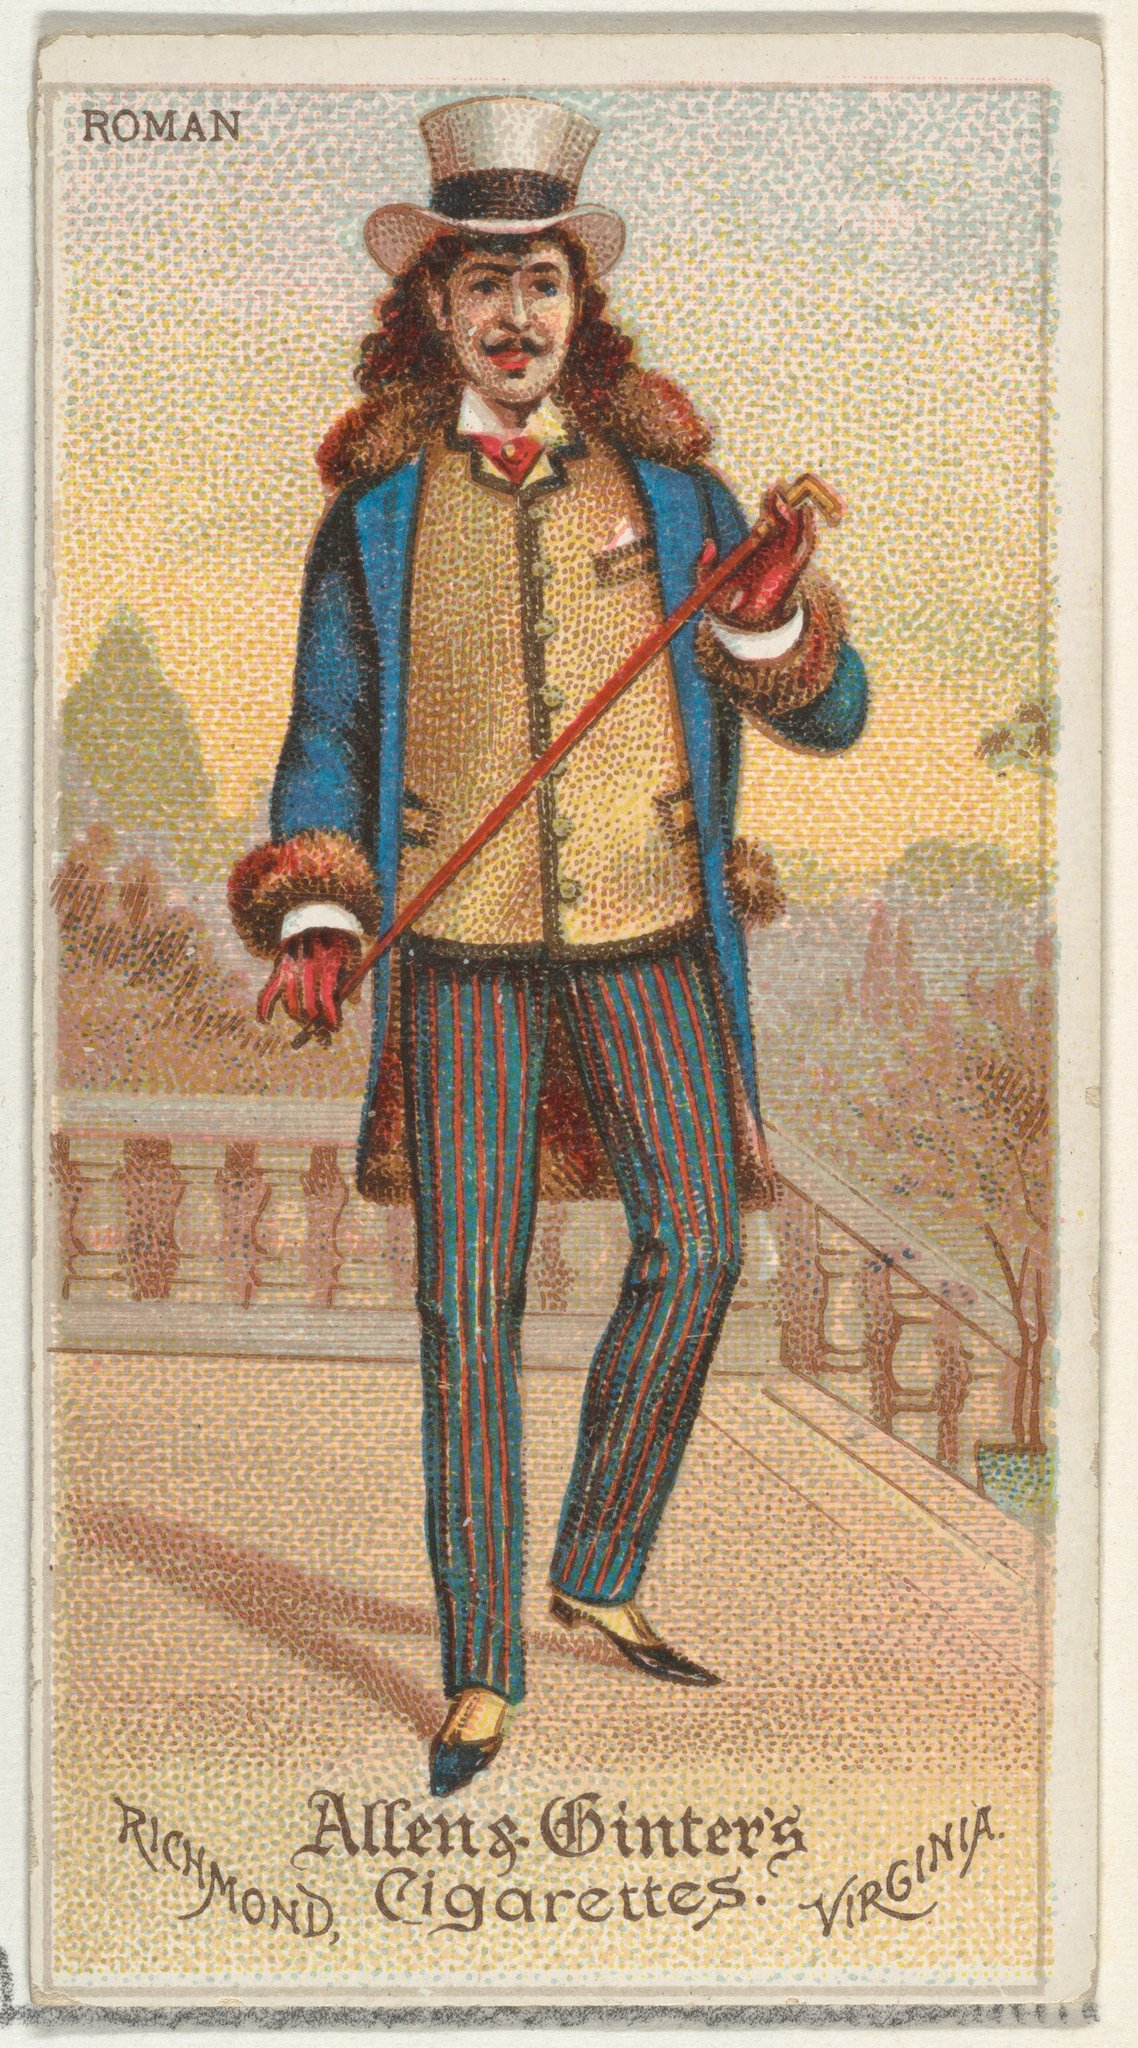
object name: print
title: Roman, from World's Dudes series (N31) for Allen & Ginter Cigarettes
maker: allen & ginter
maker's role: publisher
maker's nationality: american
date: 1888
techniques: color lithograph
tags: men